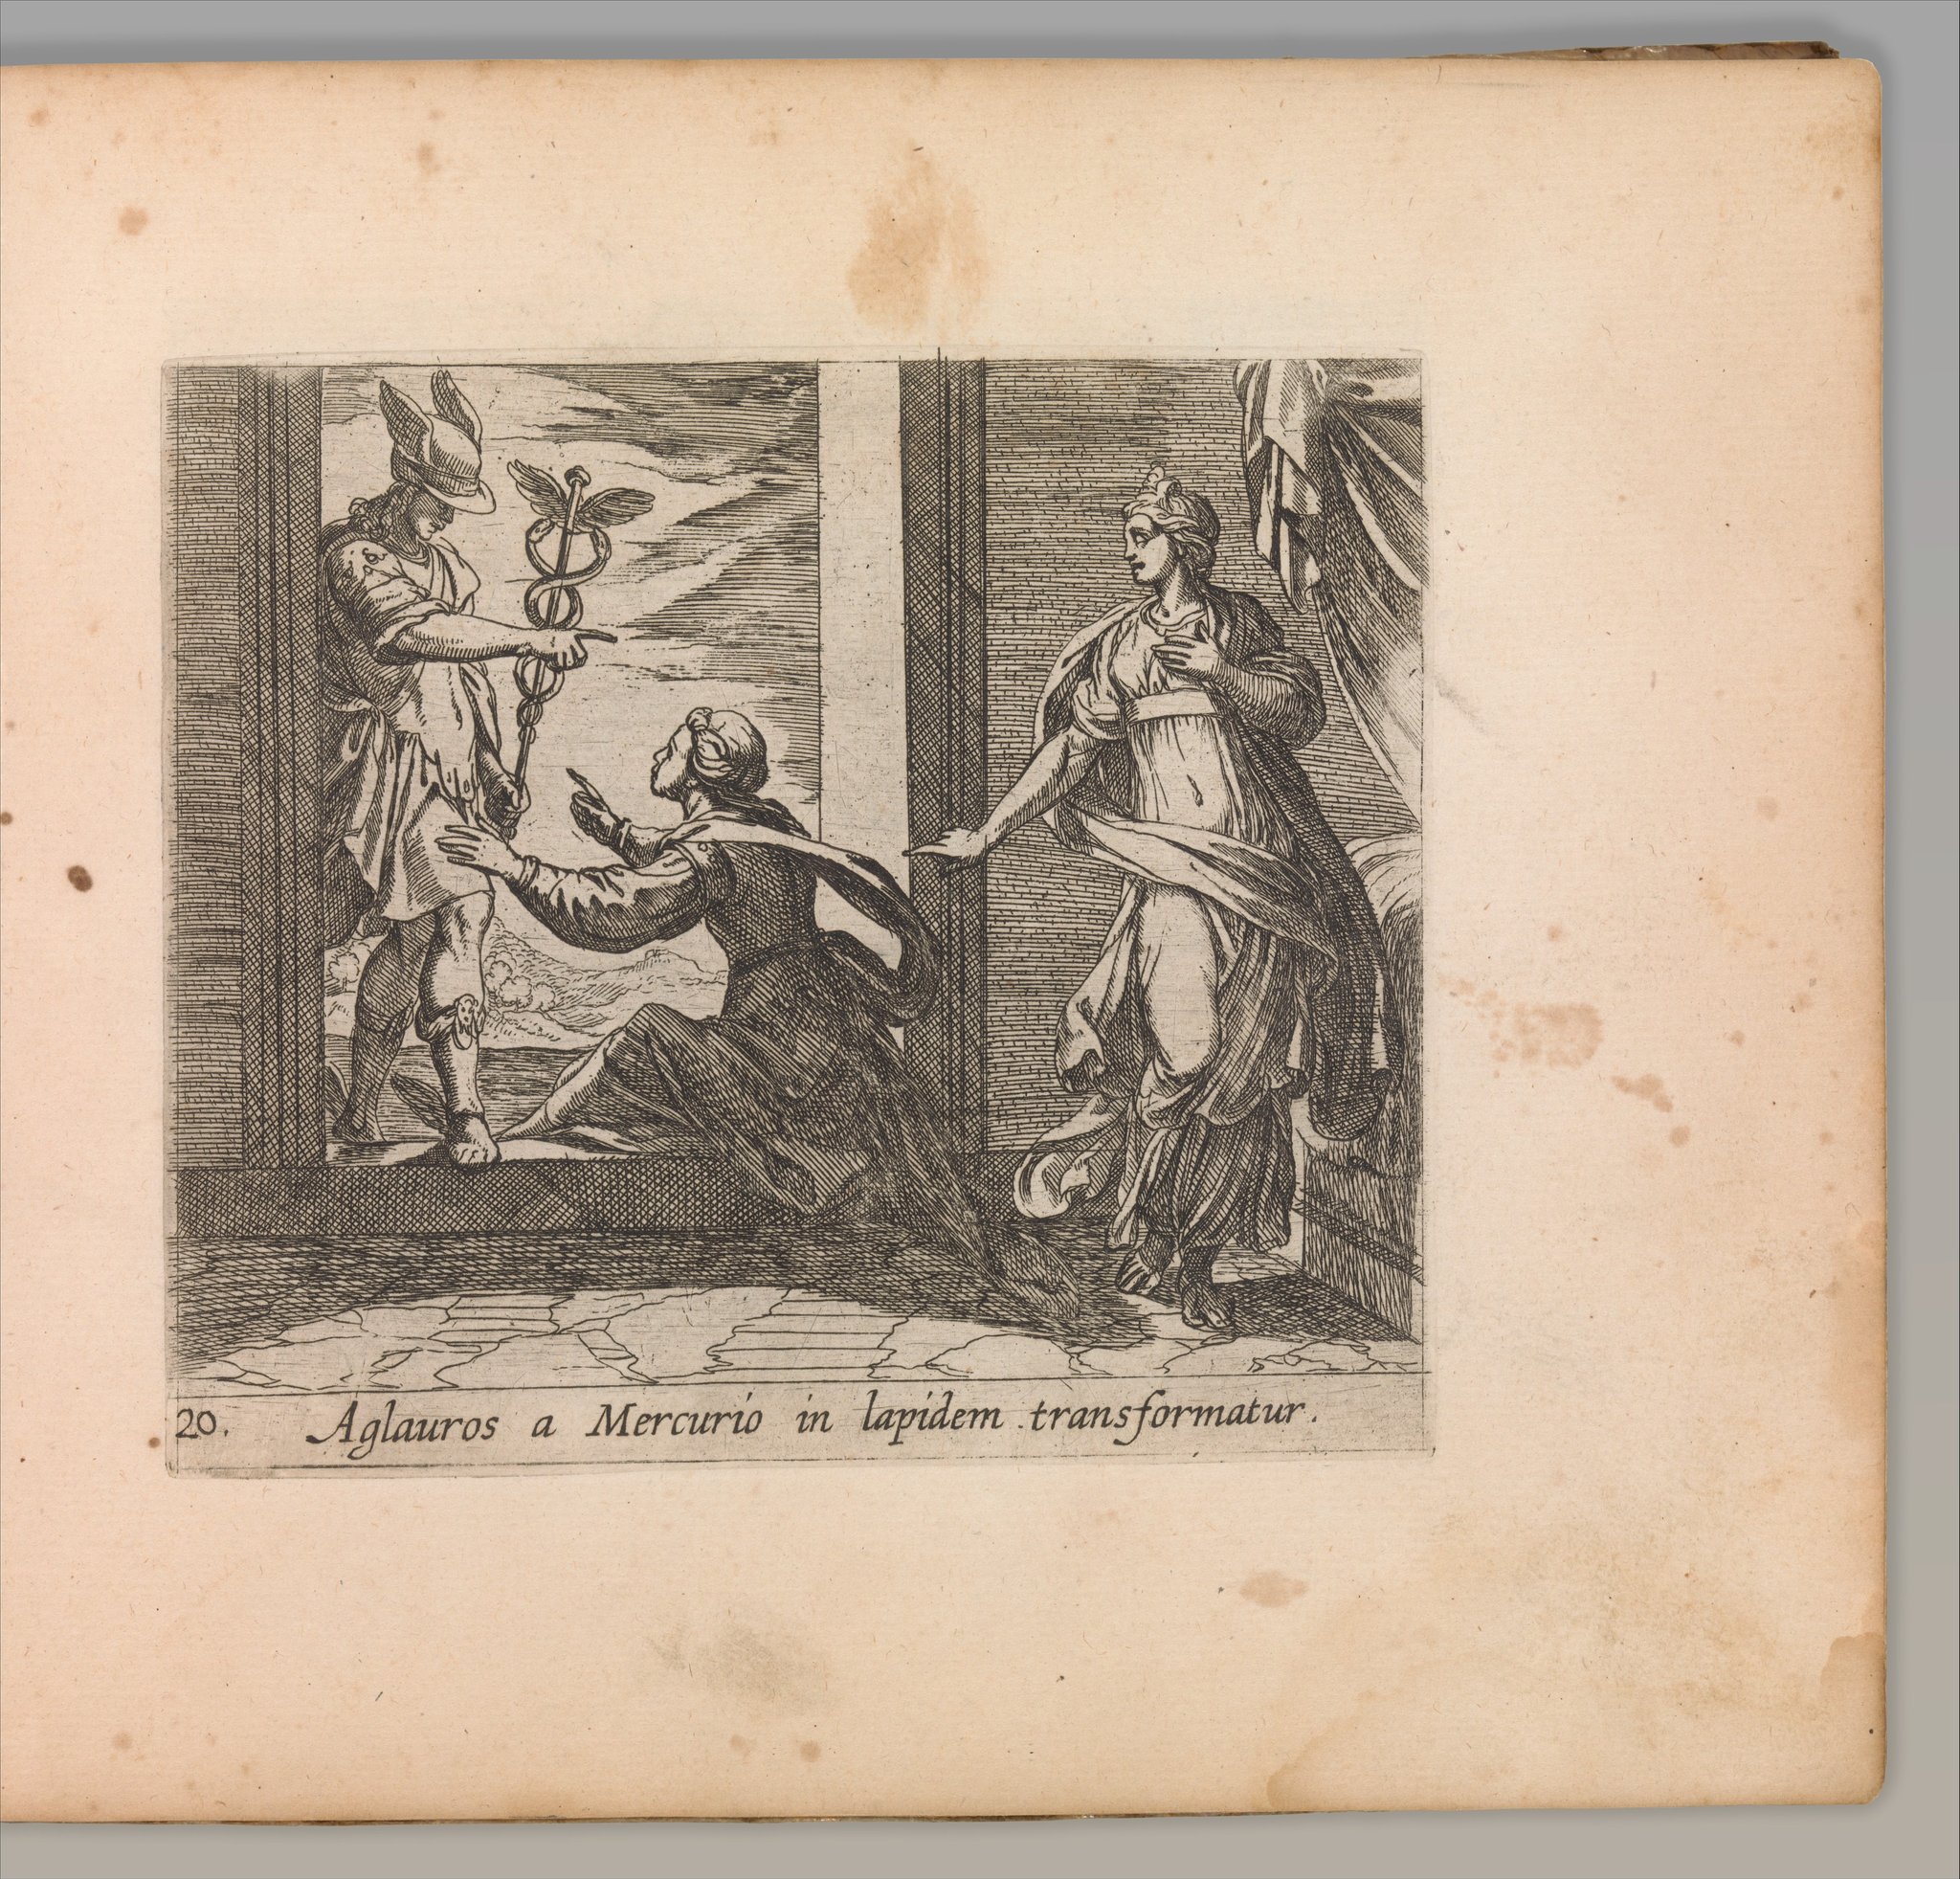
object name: print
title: Mercury Turning Aglauros to Stone (Aglauros a Mercurio in lapidem transformatur), plate 20 from "The Metamorphoses of Ovid" (Metamorphosean Sive Transformationum)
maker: antonio tempesta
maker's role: artist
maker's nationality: italian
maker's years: 1555-1630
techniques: etching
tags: women,mercury